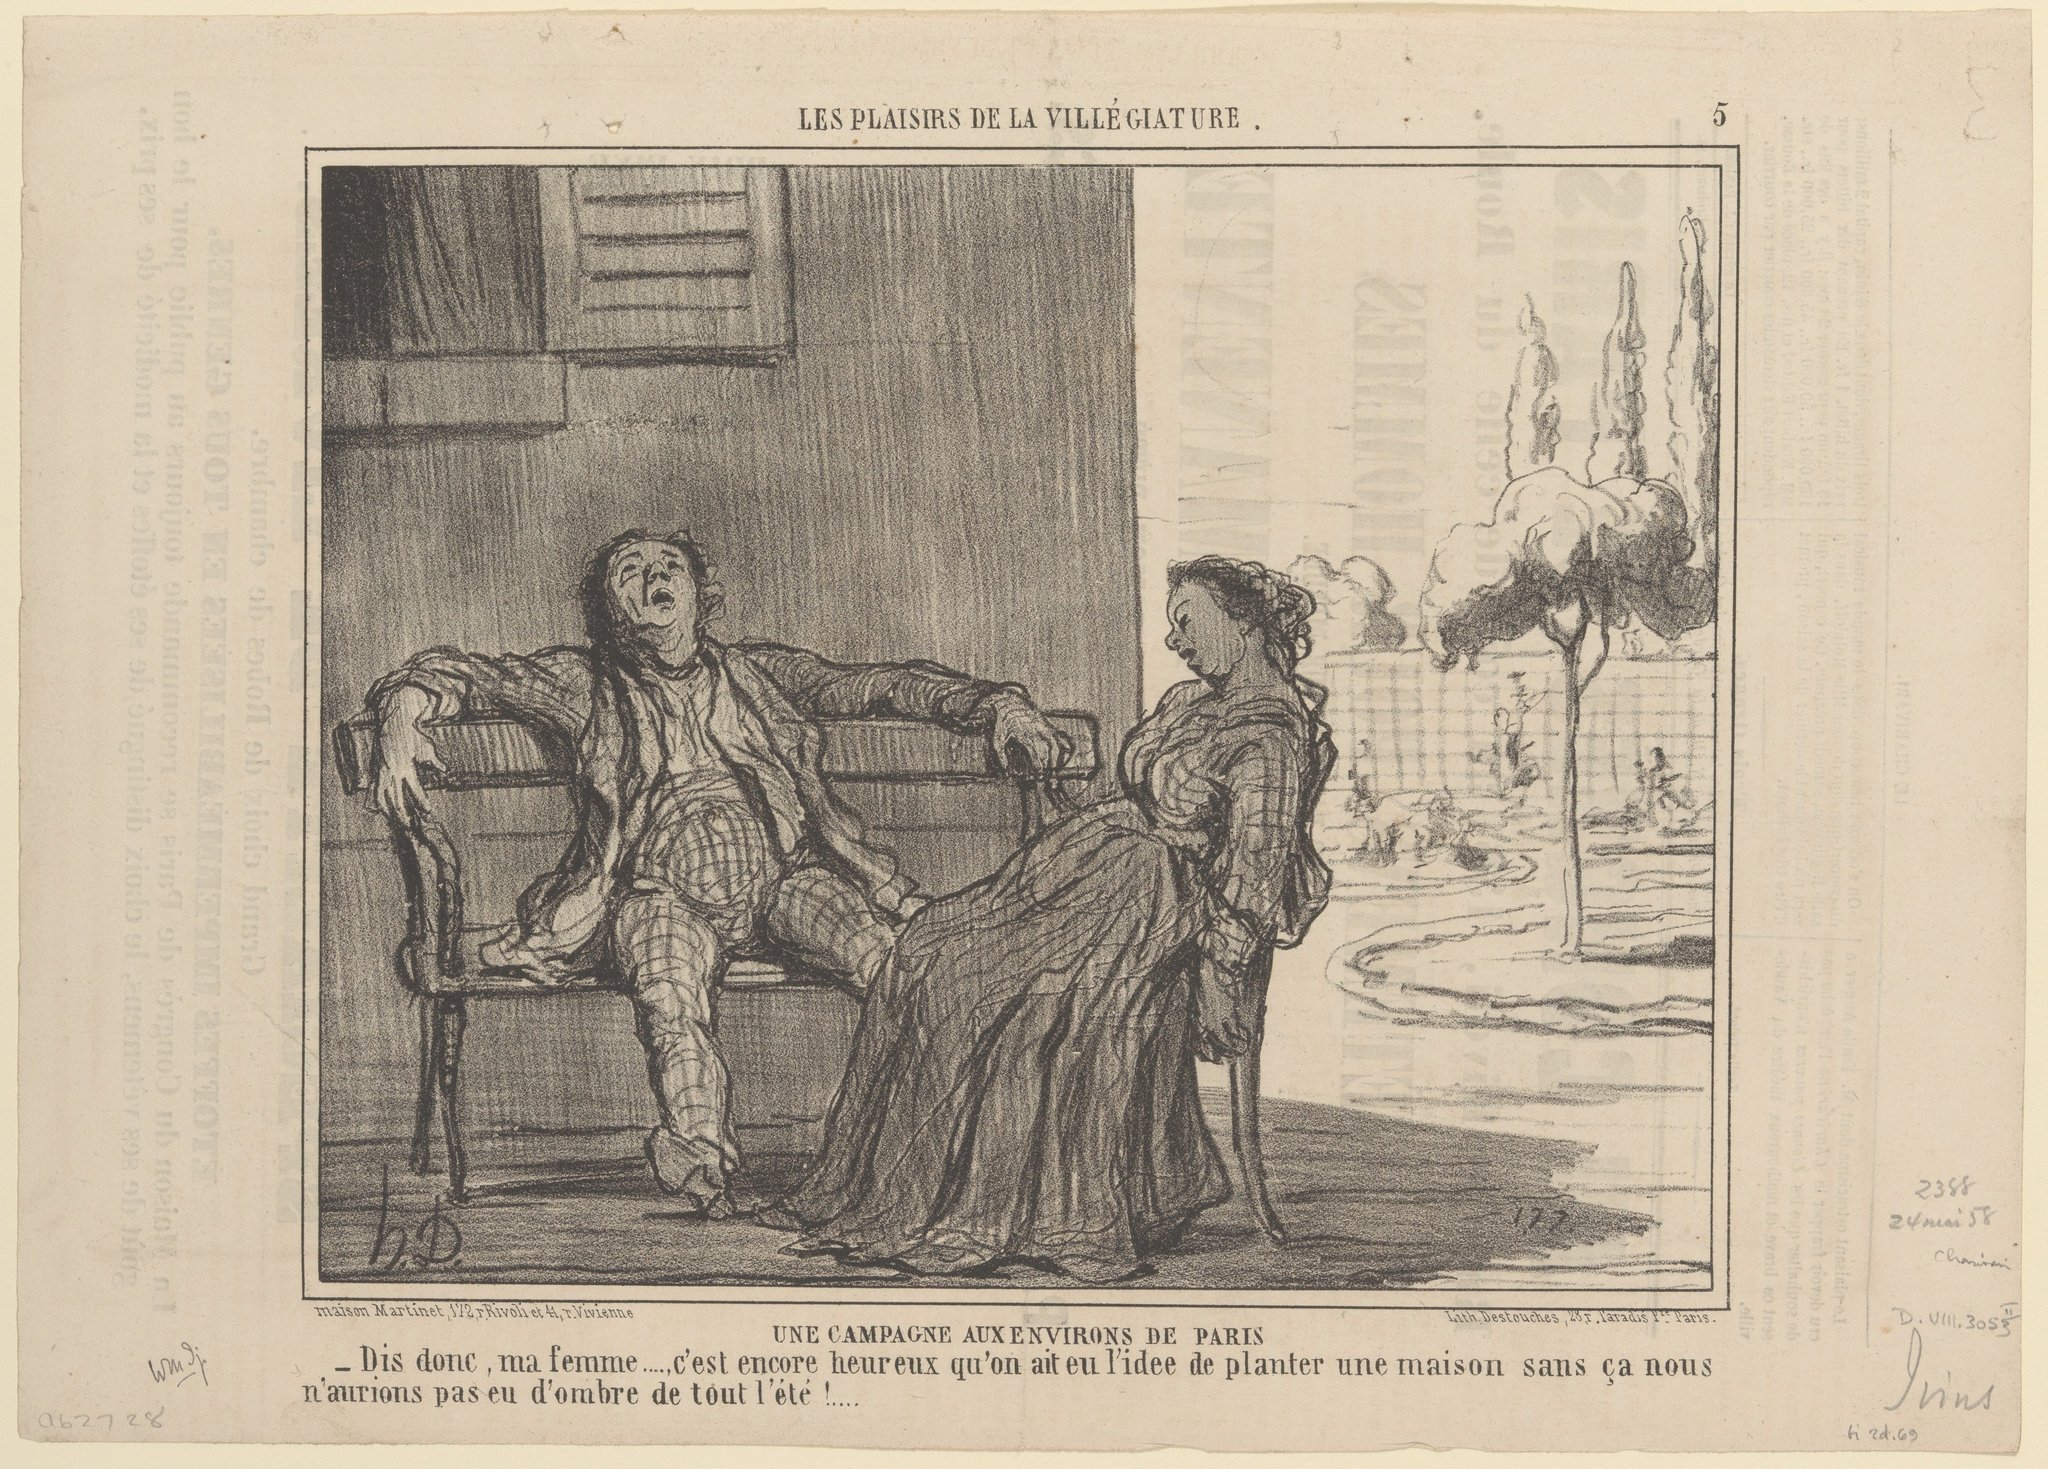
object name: print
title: A Country House Near Paris: --Well, my dear... it's a good thing we had the idea to plant a house. Without it, we wouldn't have had shade all summer! from The Pleasures of a Country Holiday, published in Le Charivari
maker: honoré daumier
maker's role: artist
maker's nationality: french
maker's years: 1808-1879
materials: paper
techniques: lithograph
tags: men,women